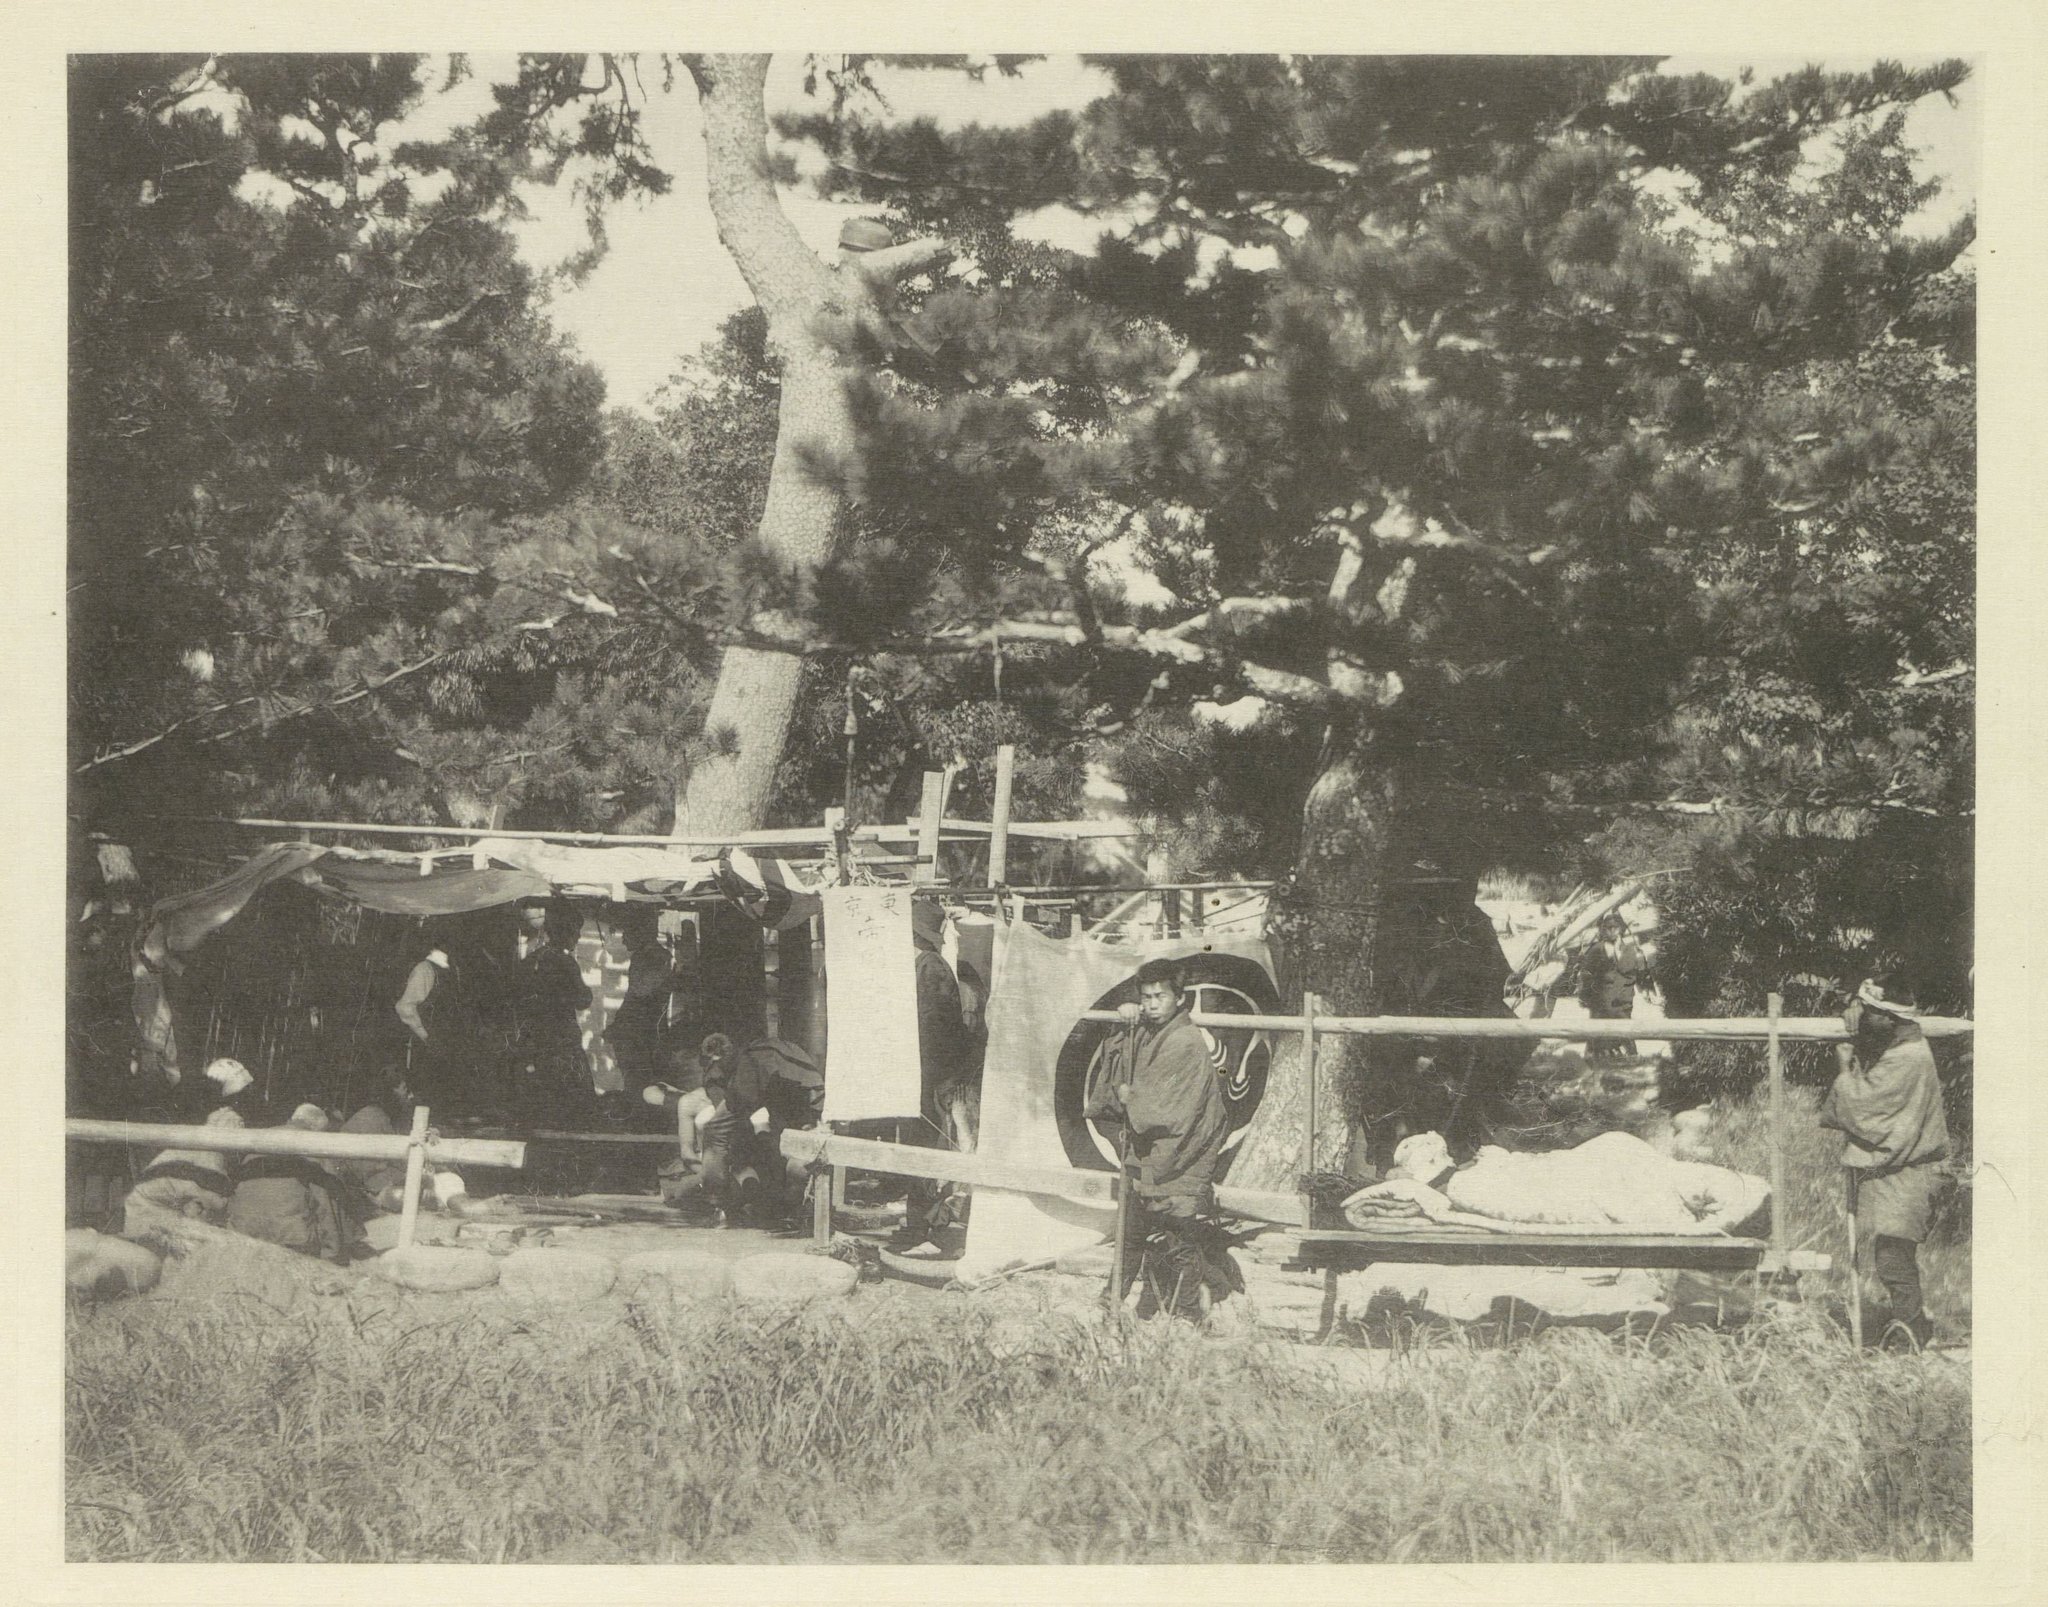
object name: photomechanical print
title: Universitair veldhospitaal in Japan na een aardbeving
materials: paper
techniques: photograph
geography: japan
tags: medical aid and nursing of the sick and wounded in a field-hospital, consequences of an earthquake